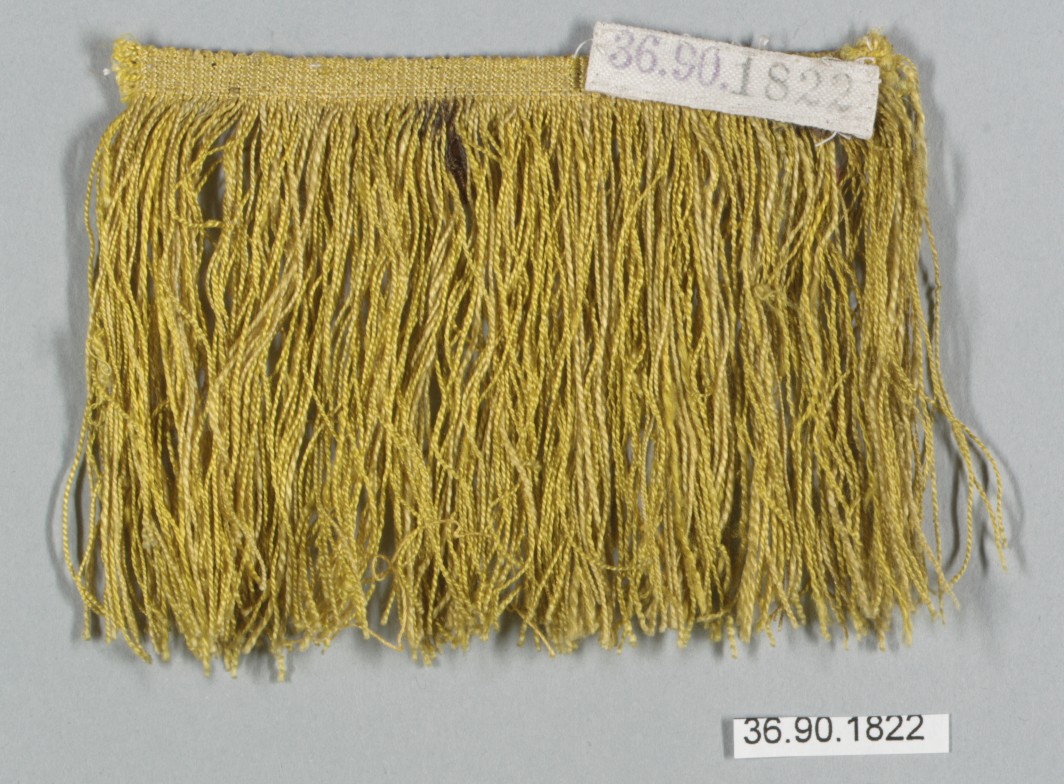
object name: fringe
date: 1734-1766